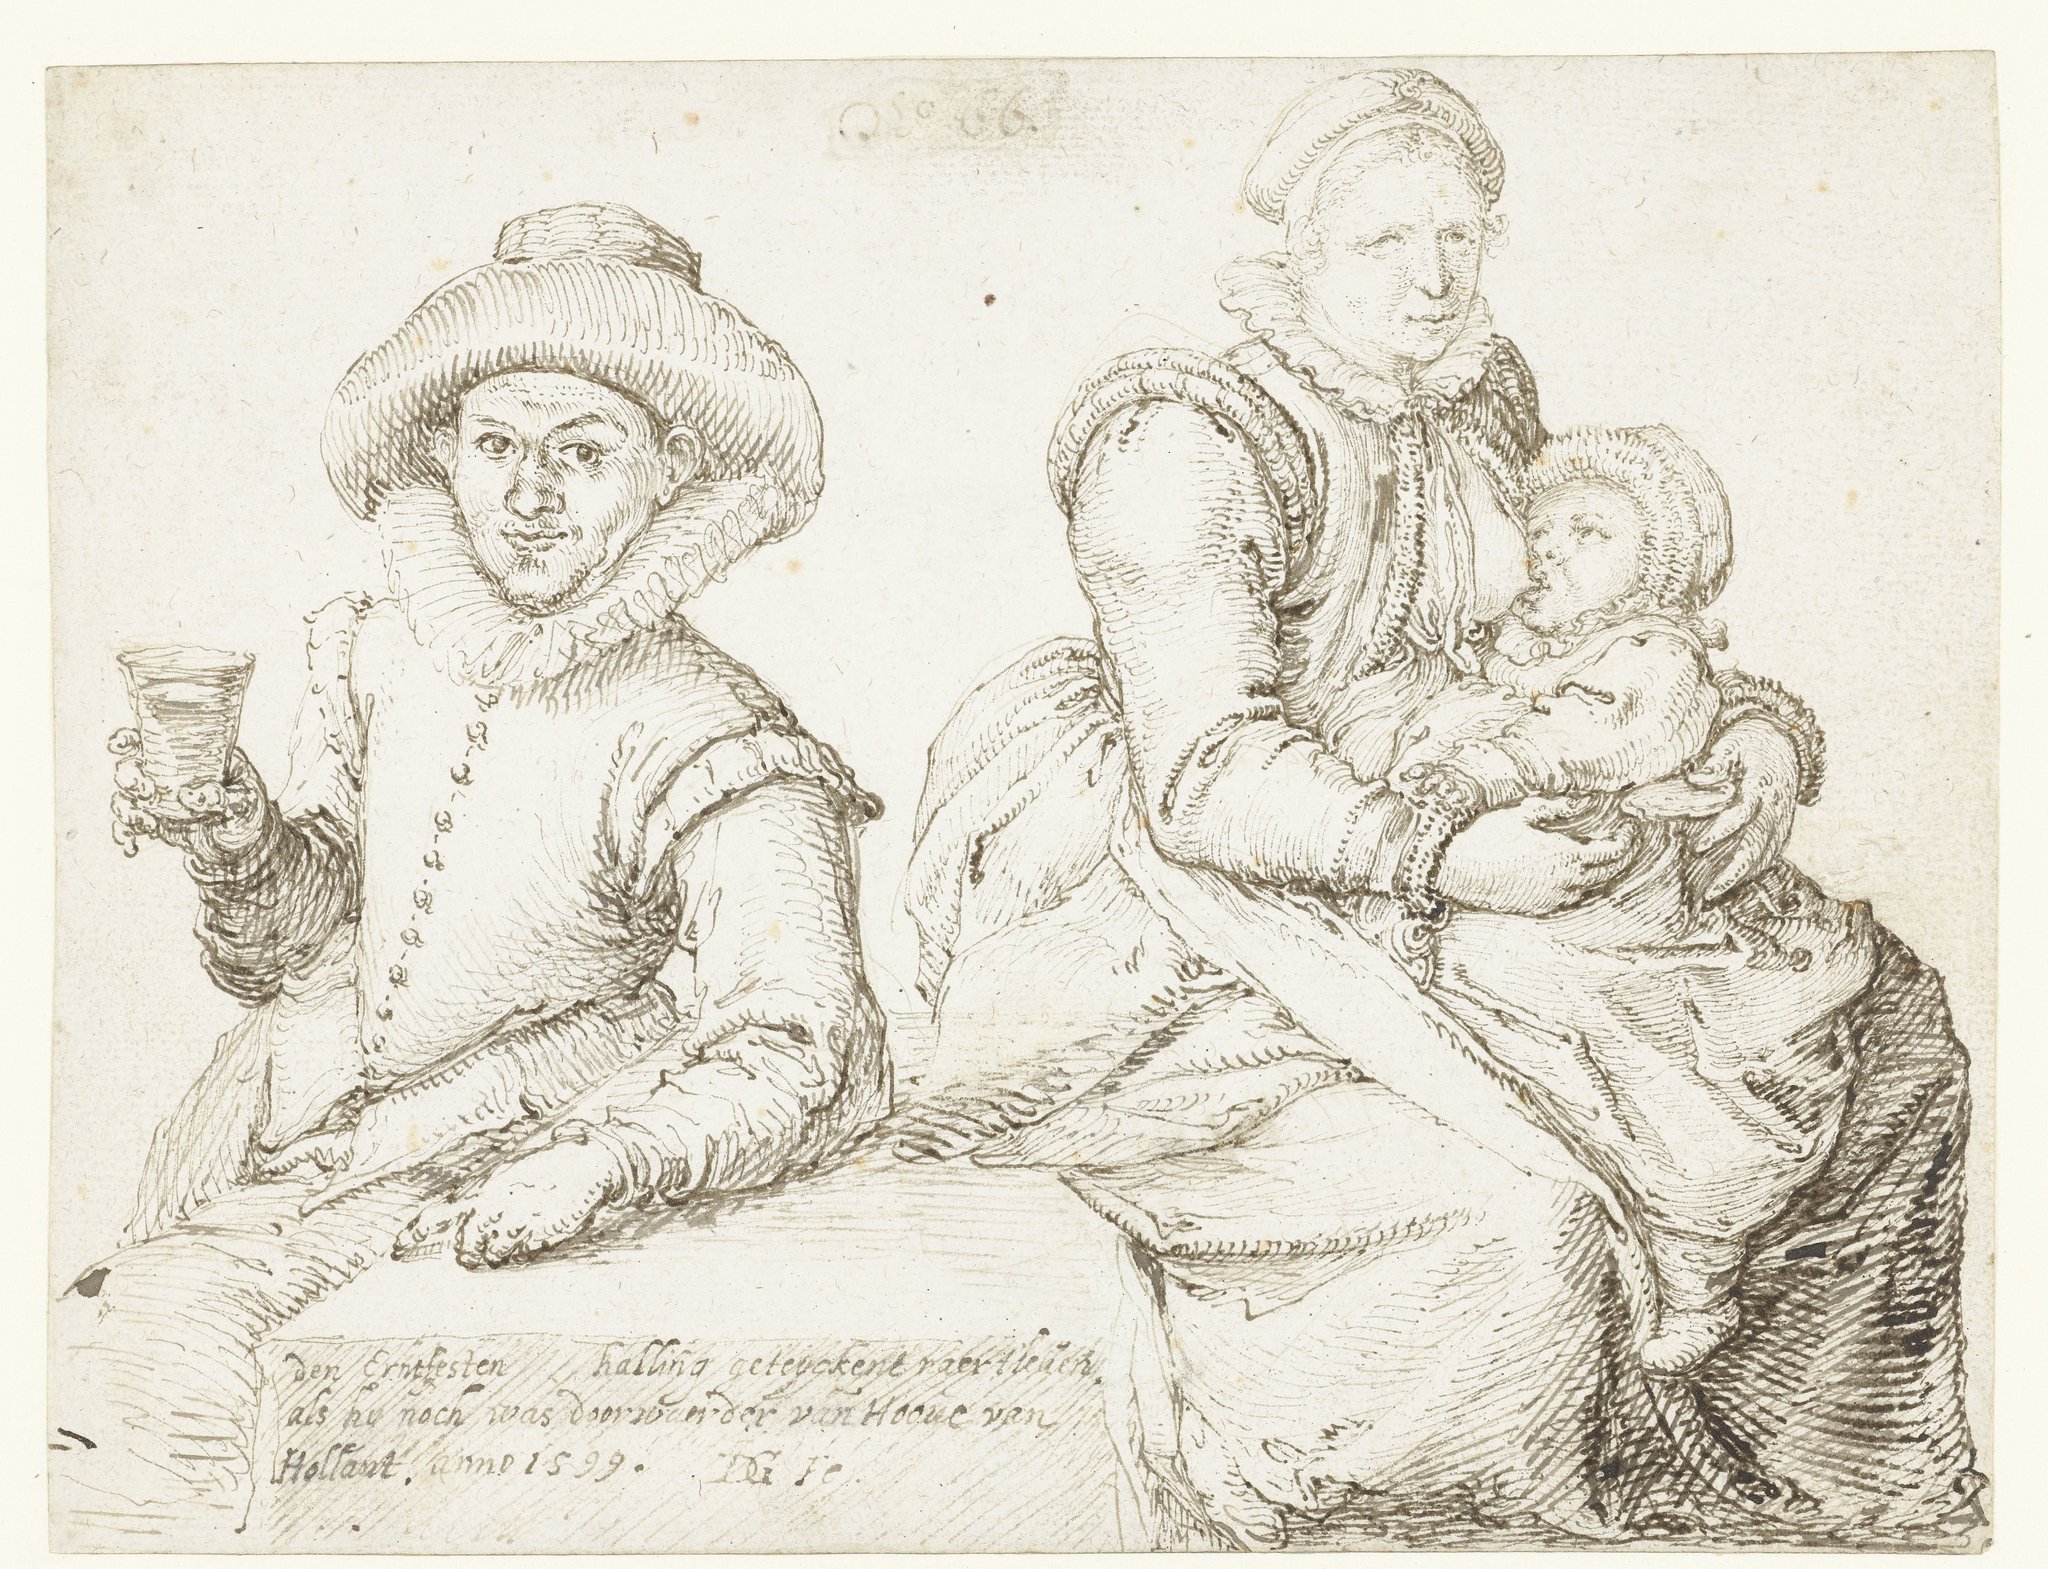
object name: drawing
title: Johannes Hallinck en een vrouw met kind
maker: jacques de gheyn (ii)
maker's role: painter, print maker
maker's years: 1565-1629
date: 1599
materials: ink, paper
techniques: pen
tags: dordrecht, mayor, nursing, suckling, neck-gear ~ clothing (with name) (+ men's clothes), historical persons, head-gear: hat (+ men's clothes), head-gear: cap (+ women's clothes), dress, gown (+ women's clothes), clothing for the upper part of the body (doublet) (+ men's clothes), sleeves (+ women's clothes), clothing for the upper part of the body (with name) (+ women's clothes)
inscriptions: date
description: De man is gekleed in een wambuis met schootje* en platte schouderkleppen*. Lubbenkraag*. Op zijn hoofd een vilten hoed* met opstaande rand. De vrouw heeft haar jakje* van voren geopend, zodat de baby de borst kan krijgen. Het jakje heeft dubbele schouderwrongen* . Hieronder hemd met gerimpeld kraagje* met lintsluiting. . Op het hoofd een mutsje*.